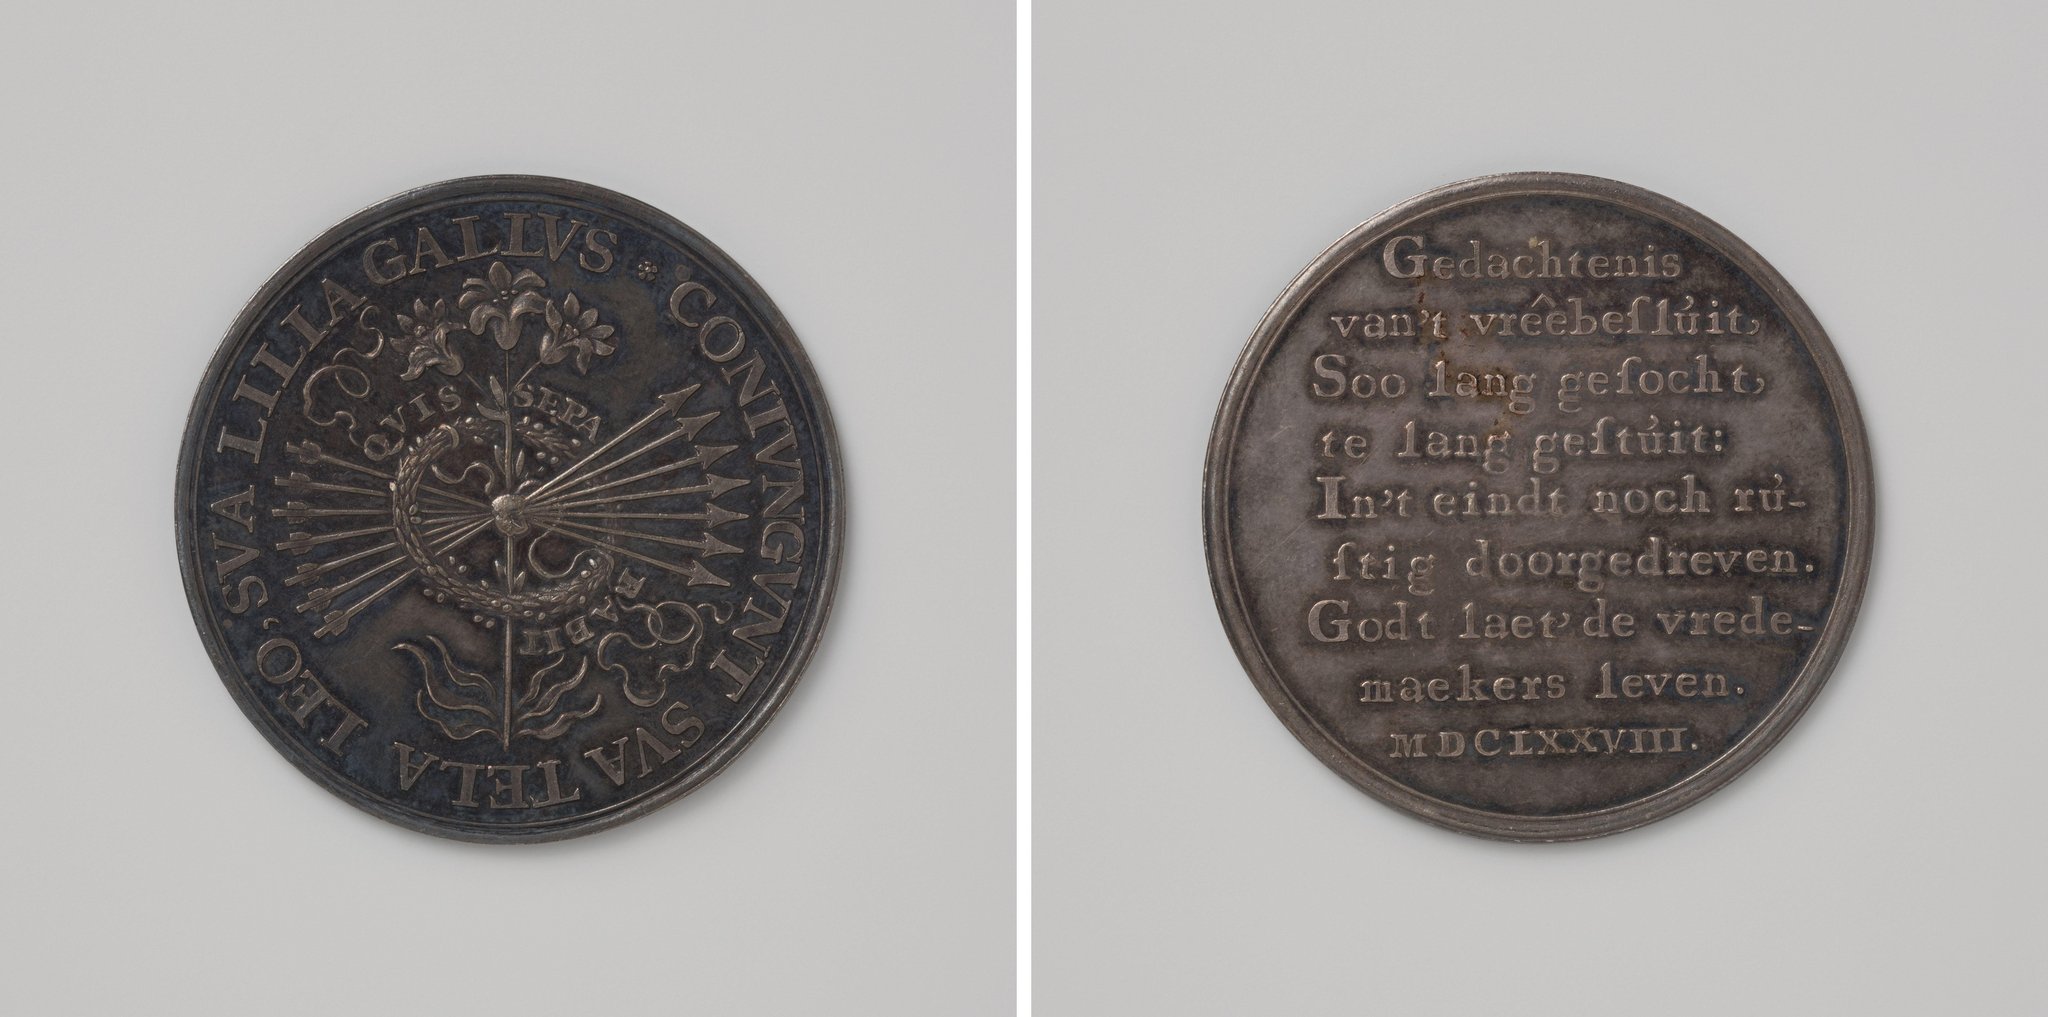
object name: history medal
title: Vrede van Nijmegen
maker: jean mauger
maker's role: medailleur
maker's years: 1648-1722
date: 1699-1703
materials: bronze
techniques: striking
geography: paris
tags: lodewijk xiv (koning van frankrijk), nijmegen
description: Bronzen penning. Voorzijde: borststuk man binnen omschrift. Keerzijde: gevleugelde Mercuriusstaf en bliksemschichten binnen omschrift; afsnede: opschrift